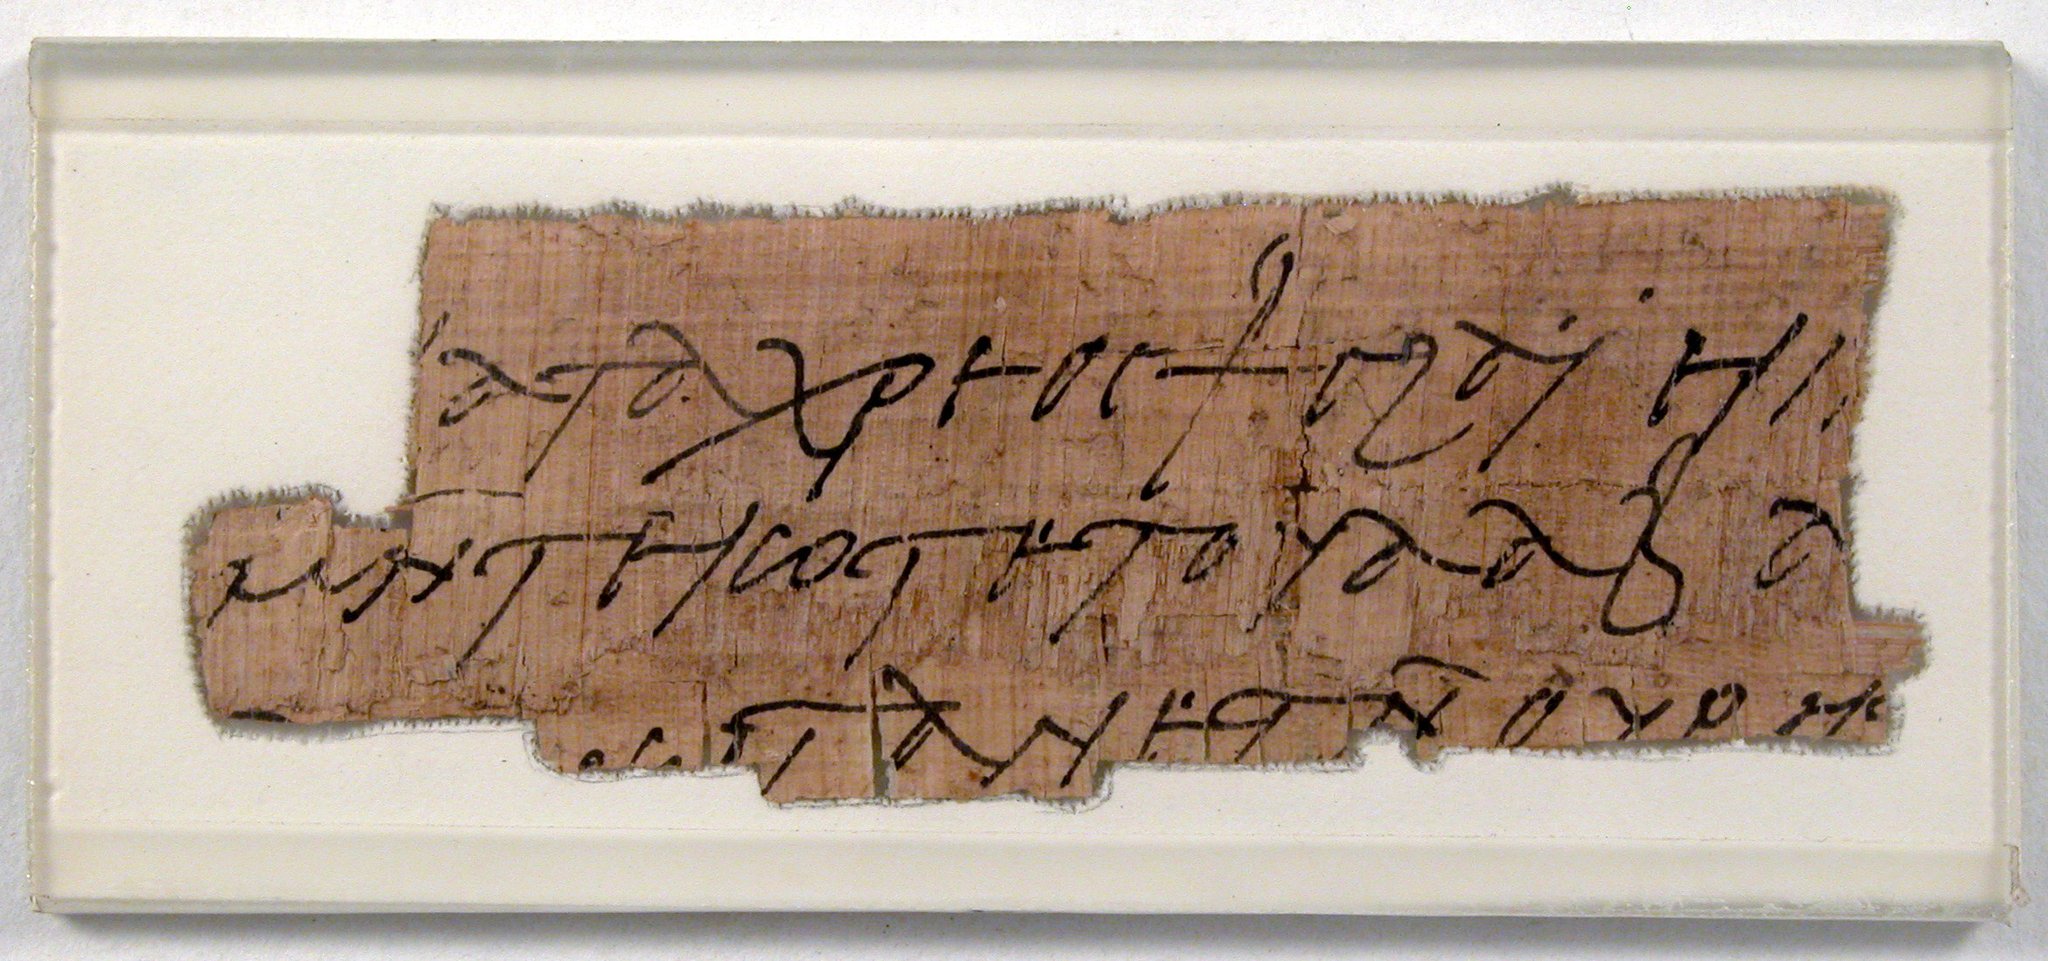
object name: fragment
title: Papyrus Fragment of a Letter from Anastasius to Epiphanius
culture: coptic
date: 601-700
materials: ink, papyrus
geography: egypt